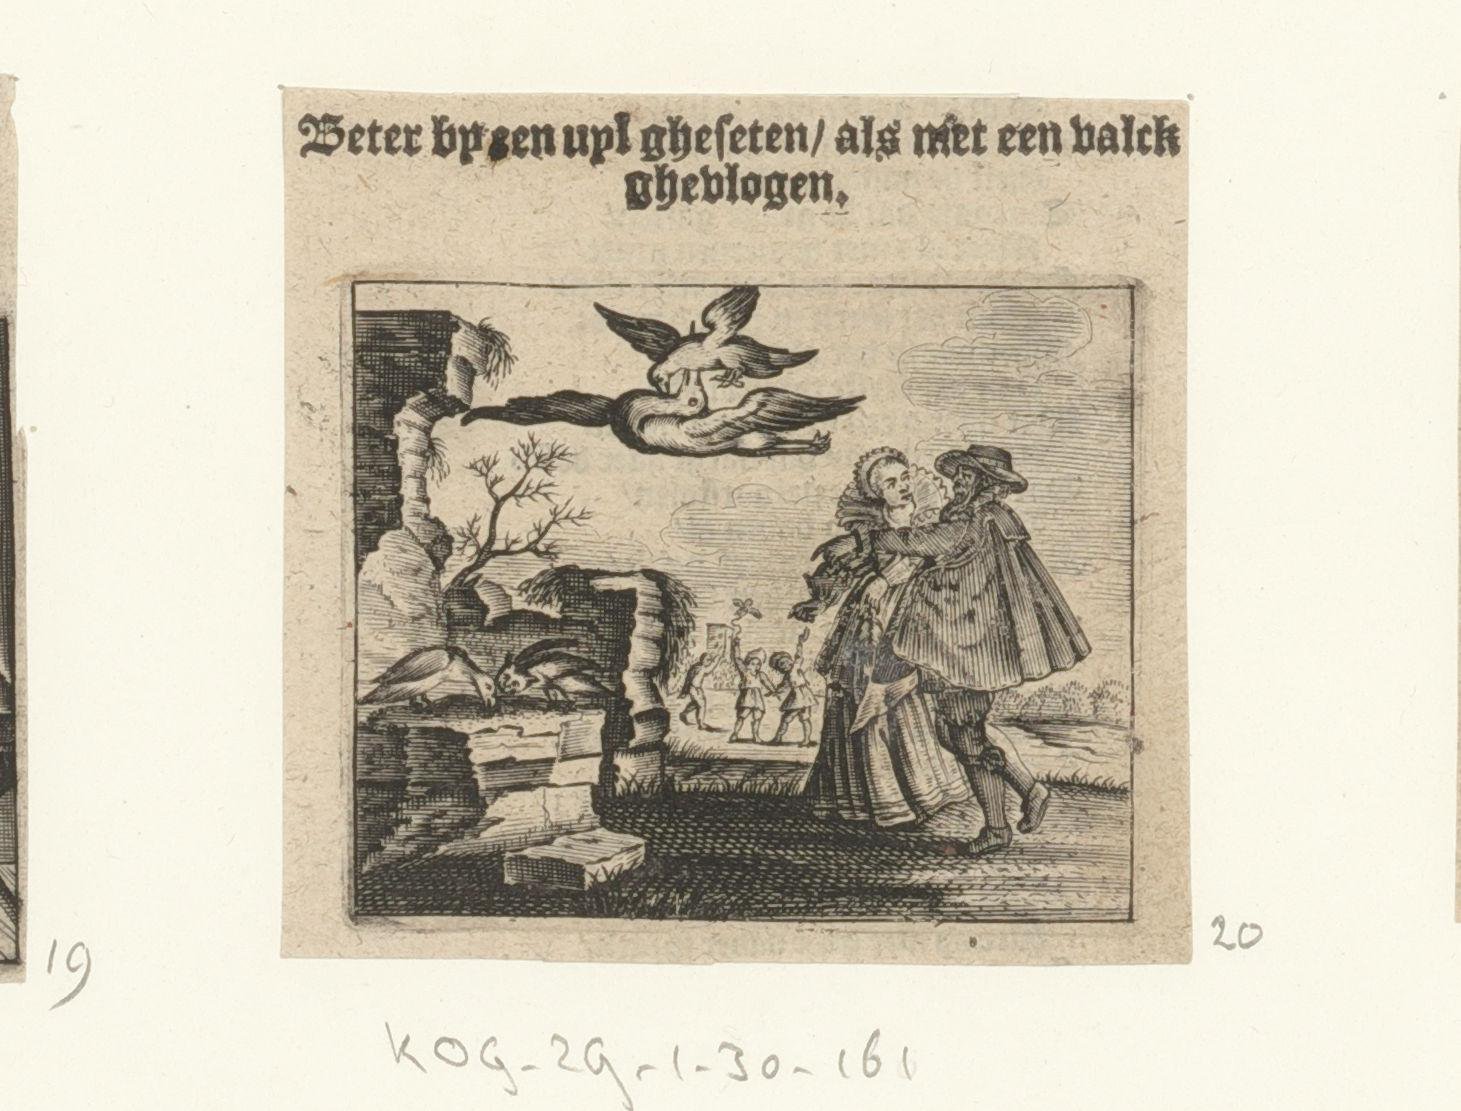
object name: print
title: Twee vogels doden elkaar terwijl een koppel danst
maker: Anonymous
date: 1635-1715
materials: paper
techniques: engraving, letterpress printing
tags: predatory birds: falcon, proverbs, sayings, etc., owls, couple of lovers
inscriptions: stamp, collector's mark: Lugt 1641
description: Veel versies van dit embleem verschenen in verschillende uitgave van Spiegel van den Ouden ende Nieuwen Tydt. Zoals: Cats, Jacob. Spiegel van den Ouden ende Nieuwen-tijt, Bestaende uyt Spreeck-woorden (...). Dordrecht: Jacob Braat, 1647. Maar ook in andere publicaties (1665, 1671, 1715, 1722).